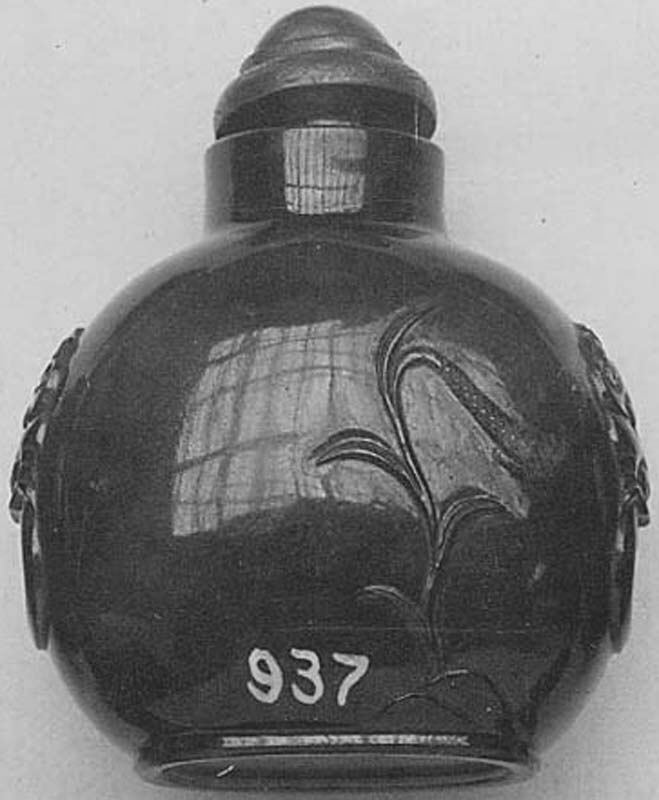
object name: snuff bottle with stopper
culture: chinese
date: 1701-1900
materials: coral, gilt, metal, quartz